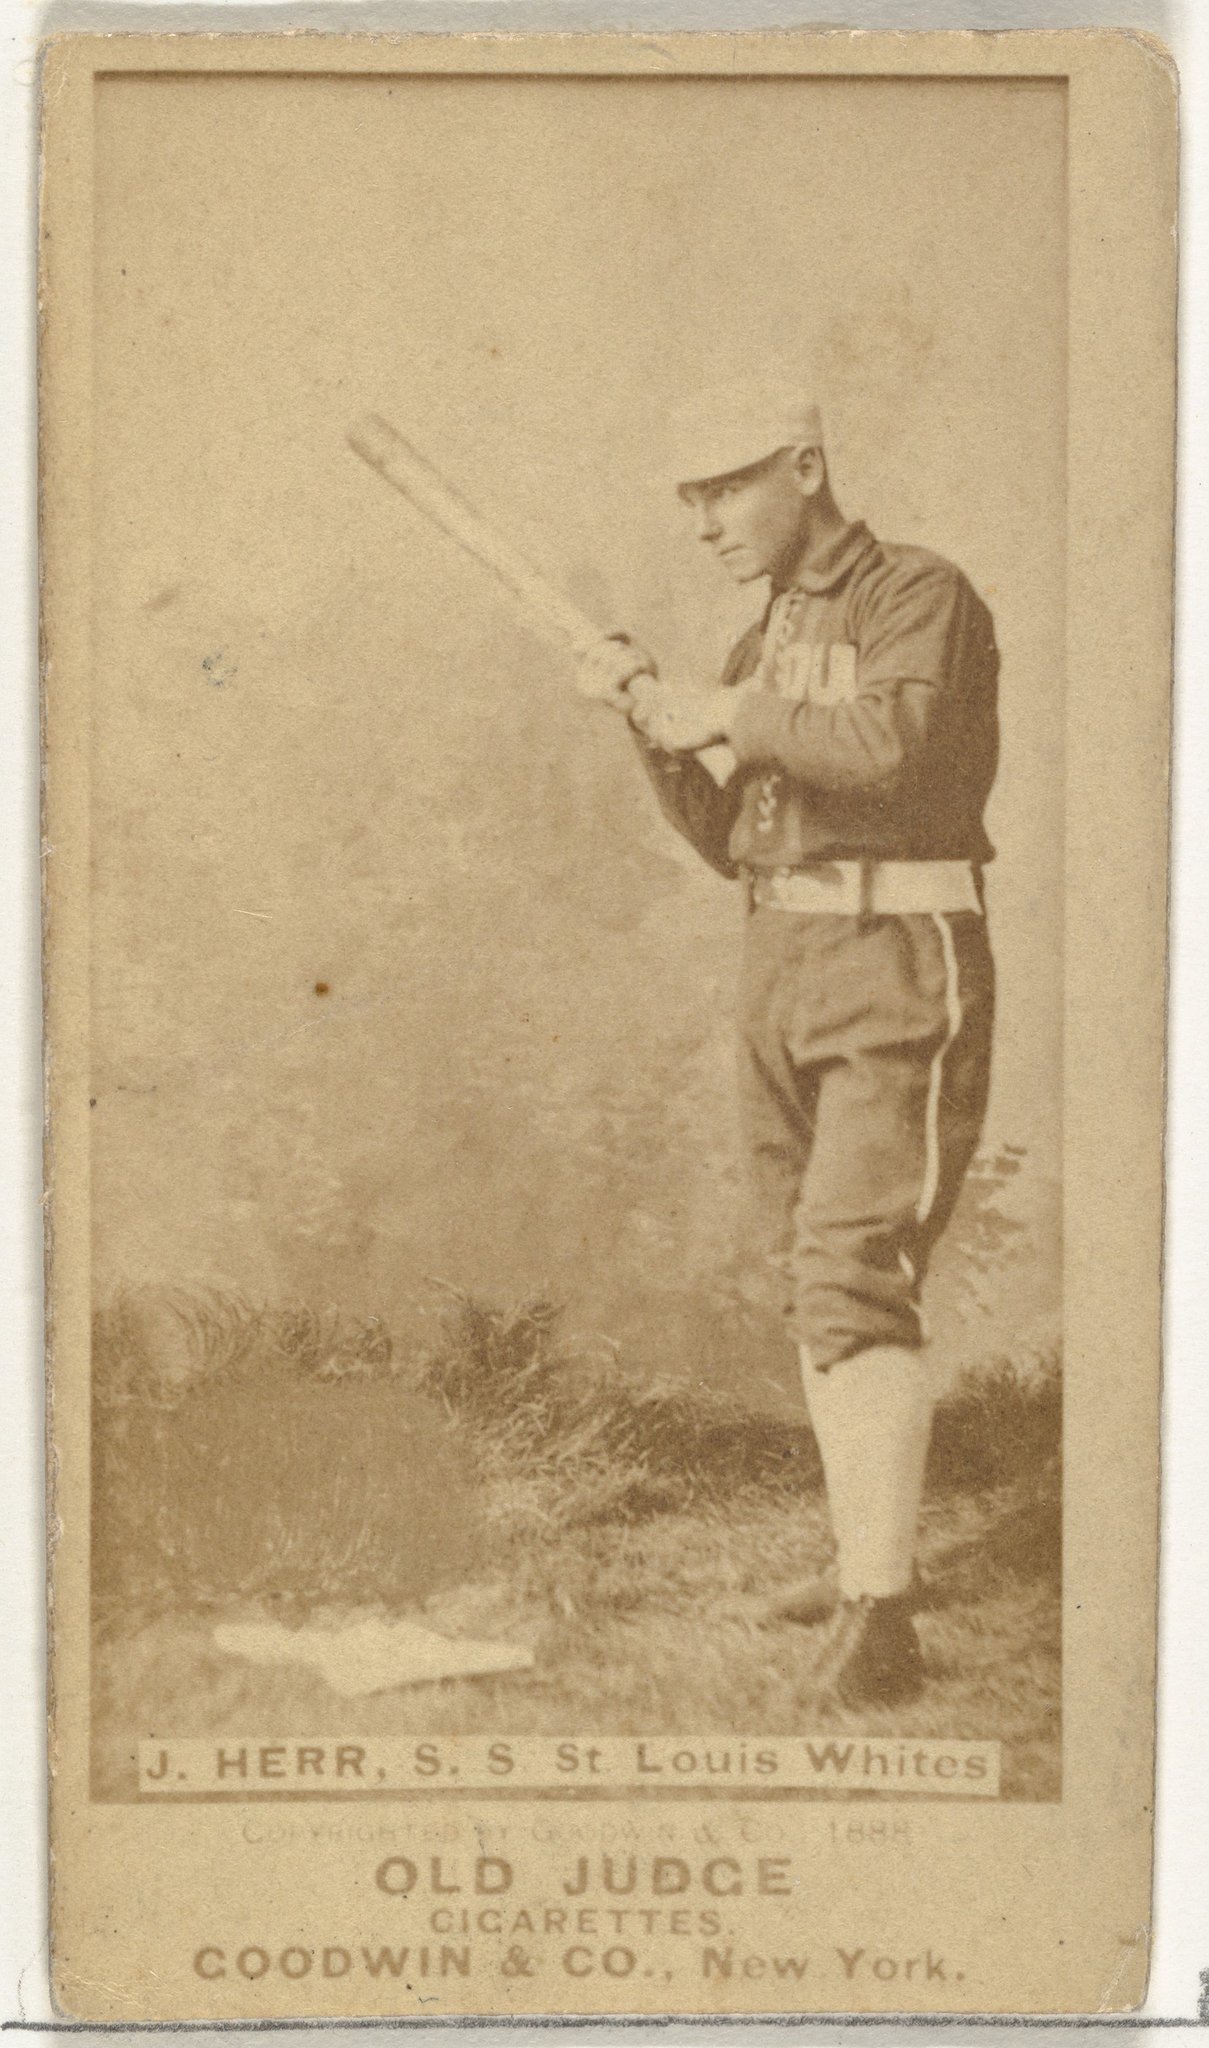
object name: baseball card, photograph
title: Herr, Shortstop, St. Louis Whites, from the Old Judge series (N172) for Old Judge Cigarettes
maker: goodwin & company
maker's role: publisher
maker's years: 1850-1950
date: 1888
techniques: albumen silver print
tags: men,portraits,baseball,athletes